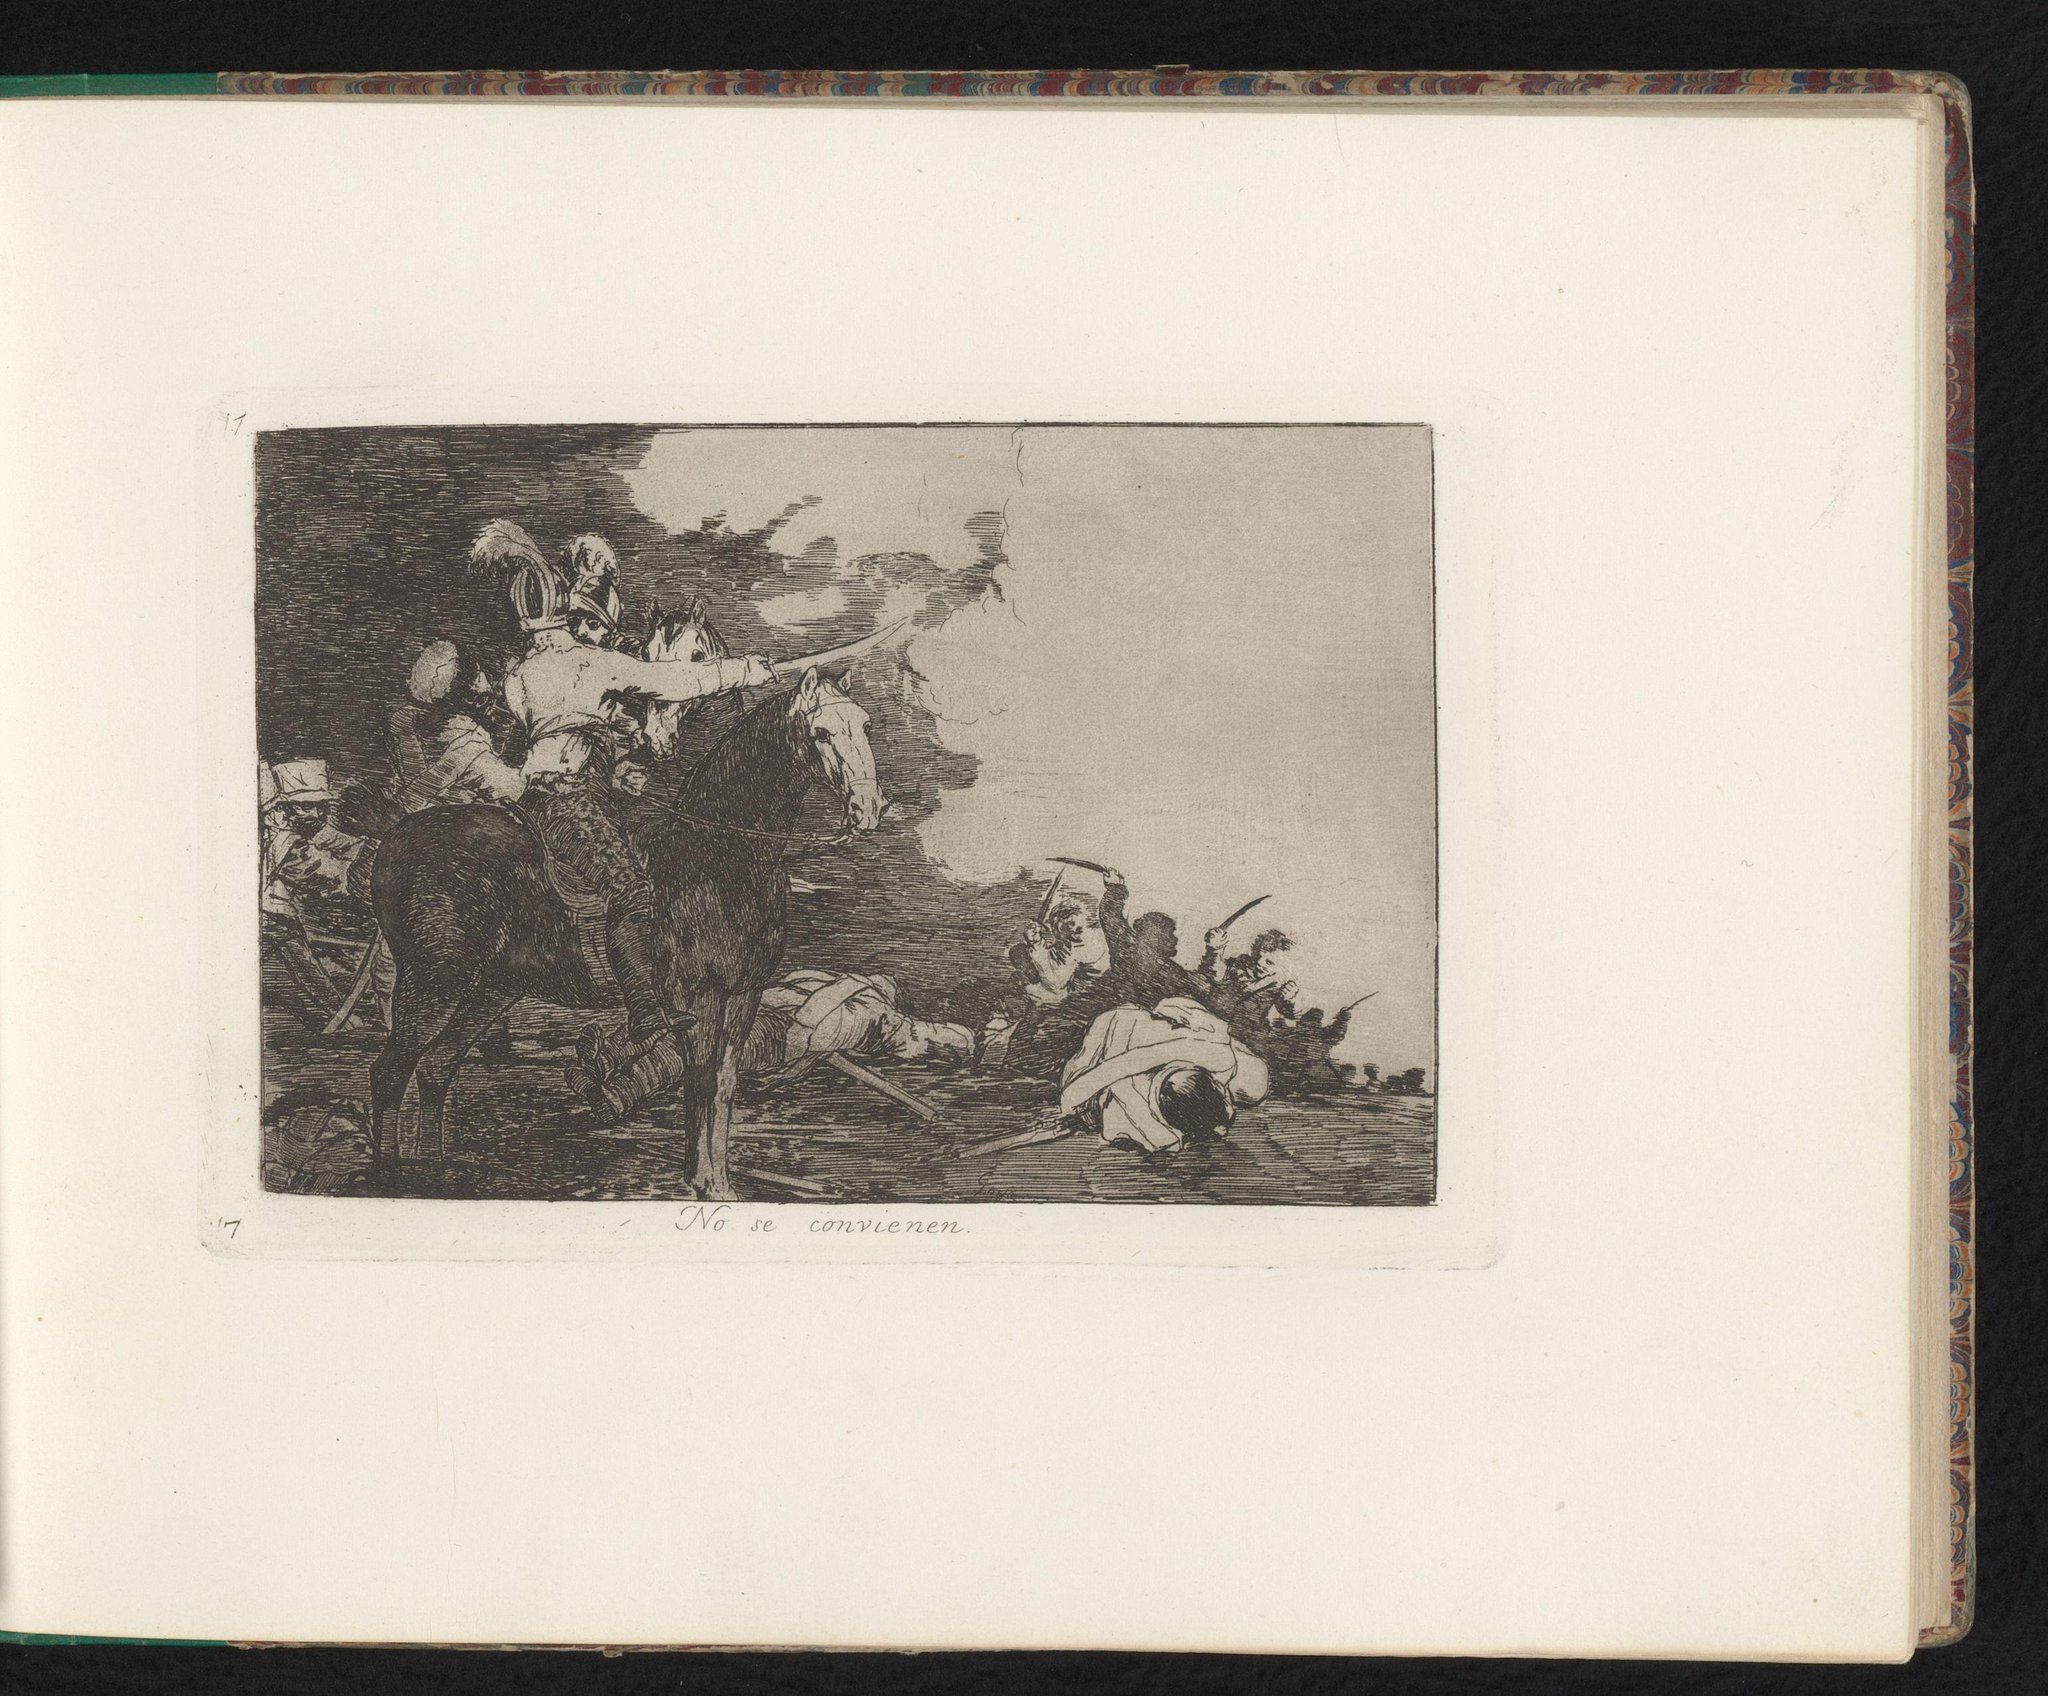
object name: album leaf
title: Los desastres de la guerra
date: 1810-1820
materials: paper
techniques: drypoint, engraving, etching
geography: madrid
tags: commander-in-chief, general, marshal, battle, spain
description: Deze prent maakt deel uit van een album.